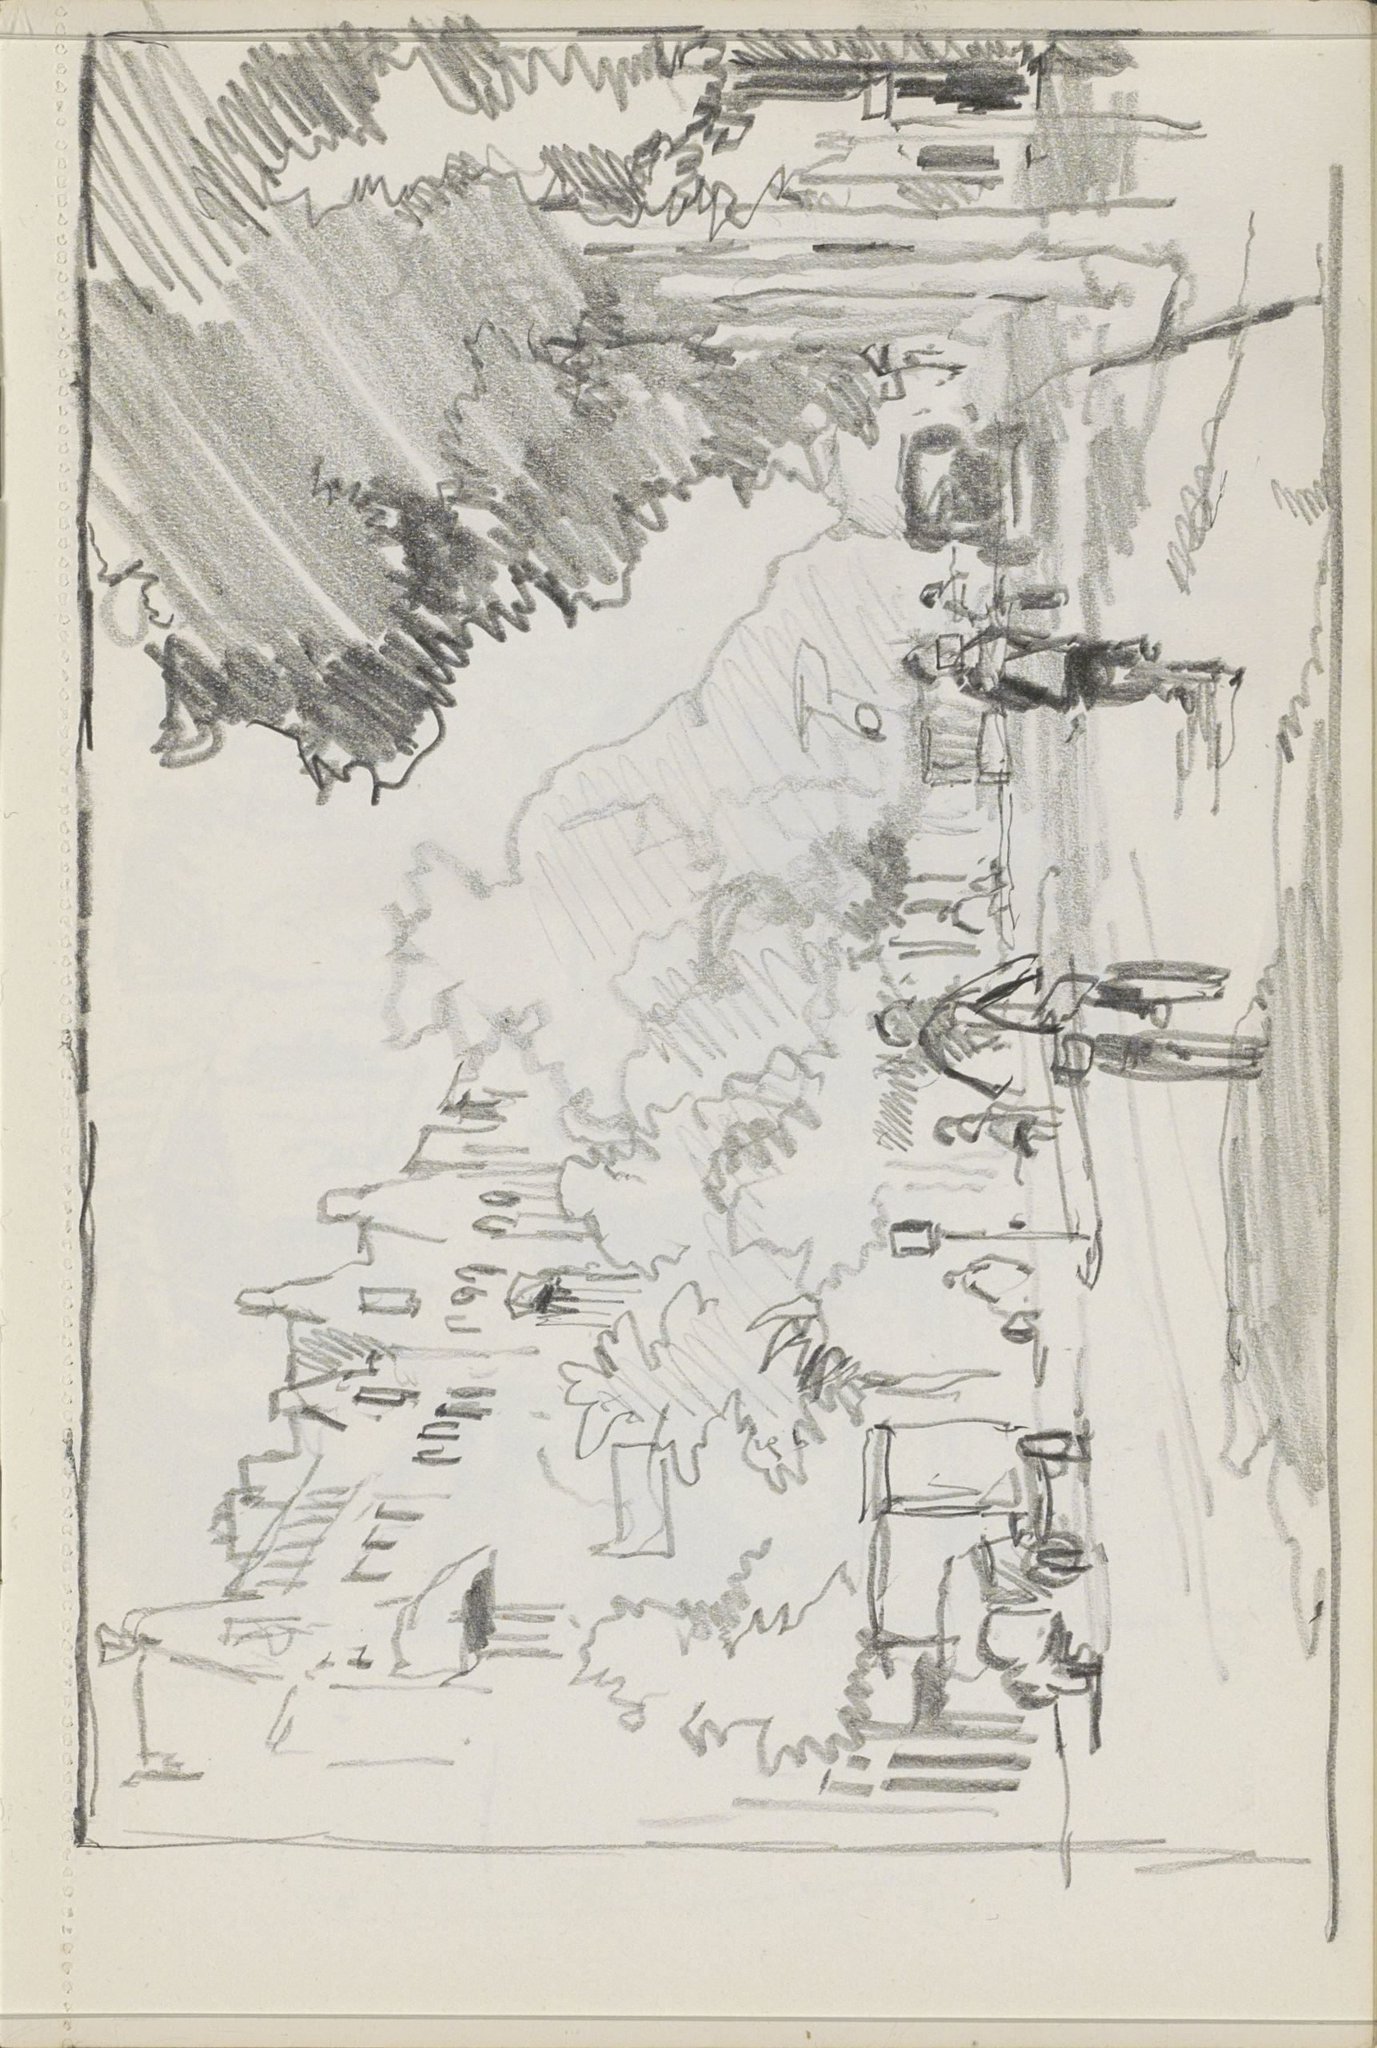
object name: sketchbook leaf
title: Fietsers en auto's op een straat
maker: cornelis vreedenburgh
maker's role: draughtsman, print maker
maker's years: 1880-1946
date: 1890-1946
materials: paper, pencil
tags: street (+ city(-scape) with figures, staffage)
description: Aan de zijden van de straat een rij huizen en een bomenlaan. Blad 40 recto uit een schetsboek met uit 75 bladen.